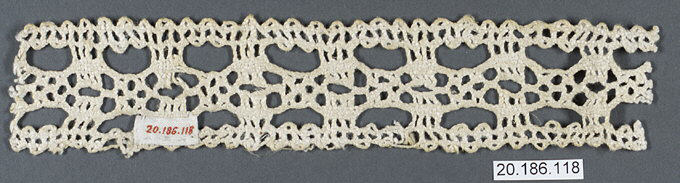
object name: insertion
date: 1501-1600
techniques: lace